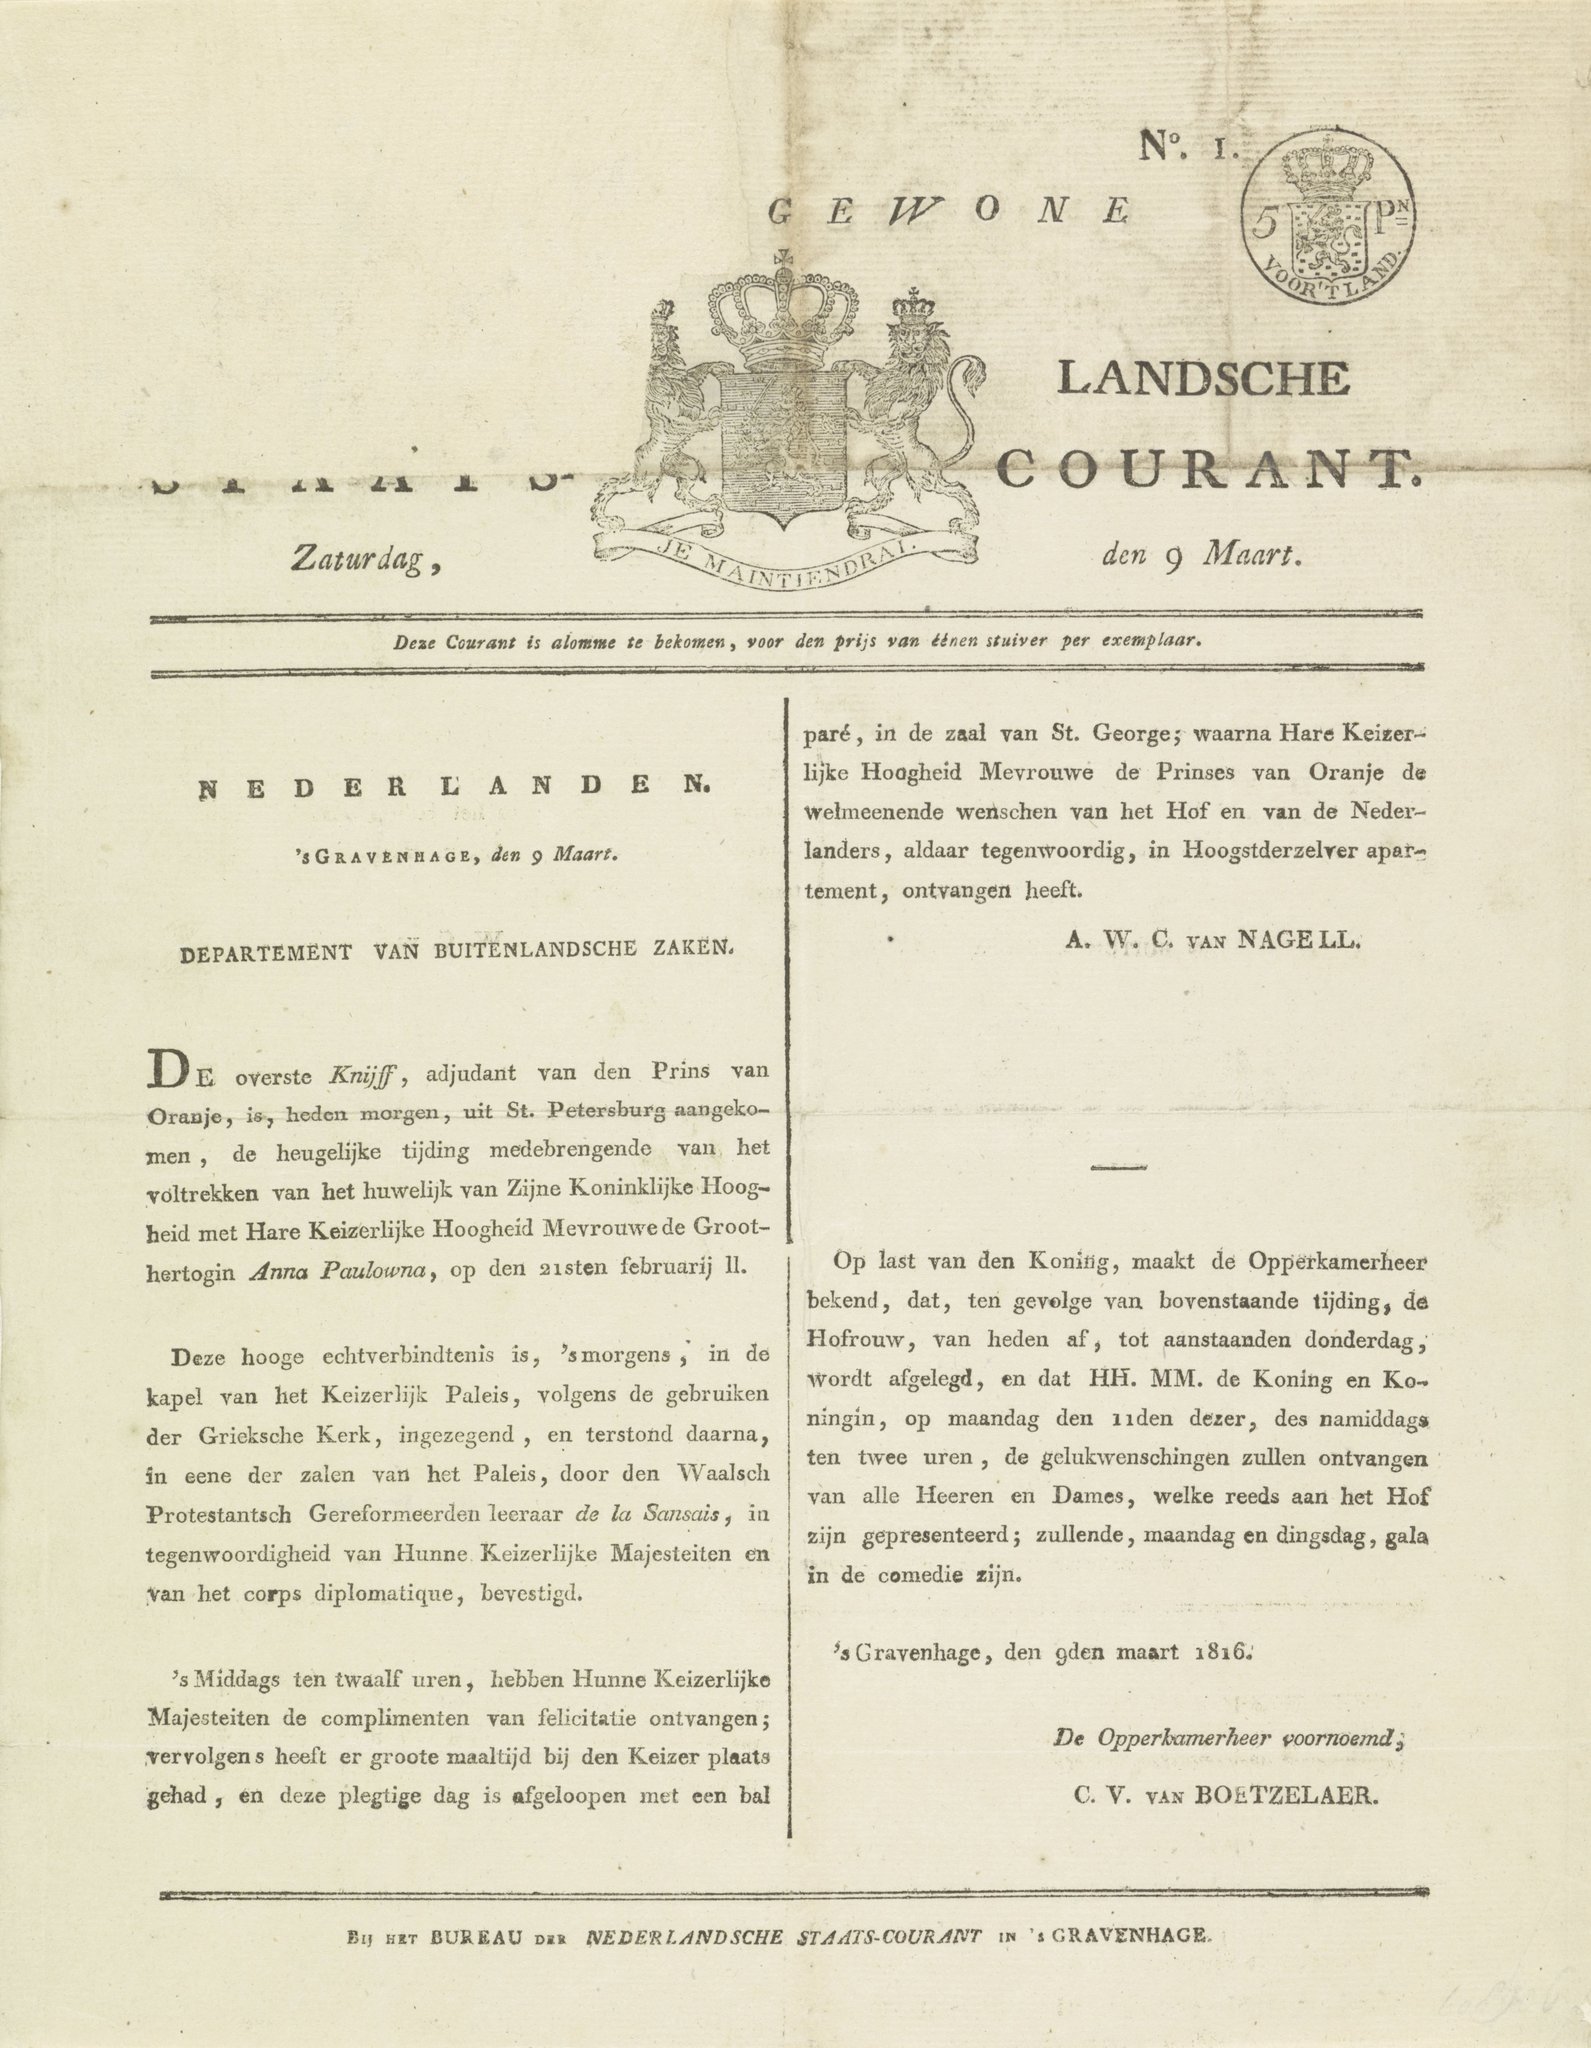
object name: text sheet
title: Nederlandsche Staatscourant van 9 maart 1816 met het bericht van het huwelijk van de prins van Oranje en Anna Paulowna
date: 1816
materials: paper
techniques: letterpress printing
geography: the hague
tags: anna paulowna romanowa, the hague, william ii of the netherlands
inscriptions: collector's mark: Lugt 2228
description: Nederlandsche Staatscourant van 9 maart 1816 met het nieuws van het huwelijk van de prins van Oranje en Anna Paulowna te Sint Petersburg op 21 februari 1816.